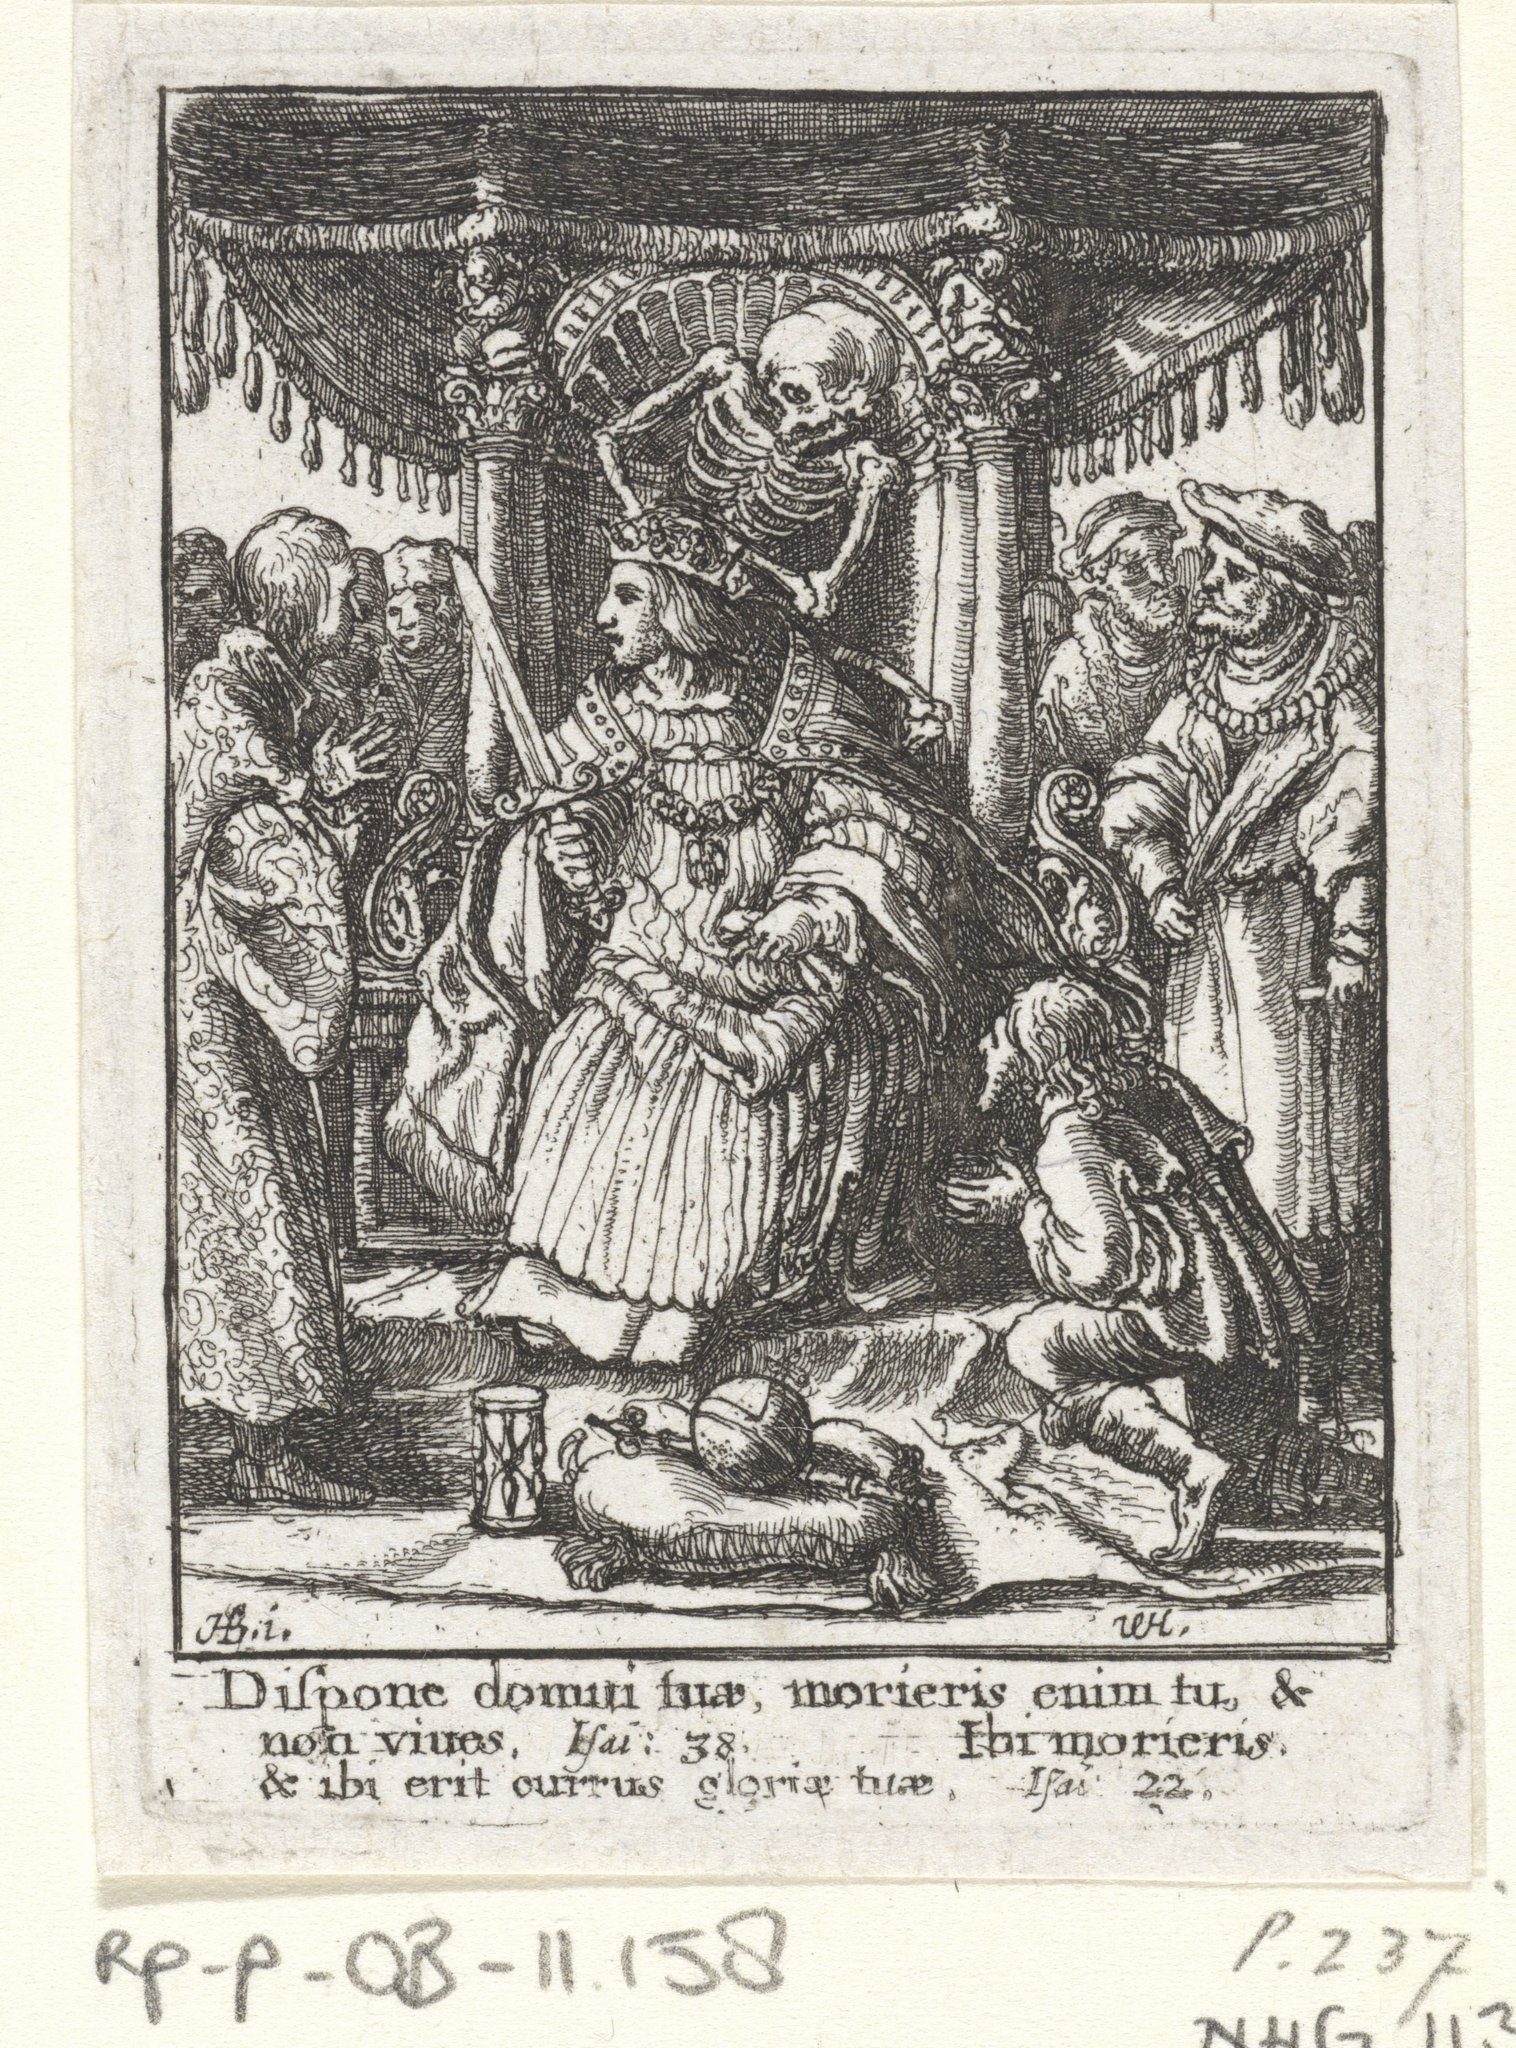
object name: book illustration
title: Dodendans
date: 1680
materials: paper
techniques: etching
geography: antwerp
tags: dance of death; death together with one or more human beings, emperor, hourglass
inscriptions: collector's mark: Lugt 240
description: De keizer troont met een zwaard in zijn handen onder een baldakijn en is omringd door onderdanen. Achter de keizer probeert de Dood hem zijn kroon af te nemen. Op de voorgrond liggen een rijksappel, scepter en een zandloper.